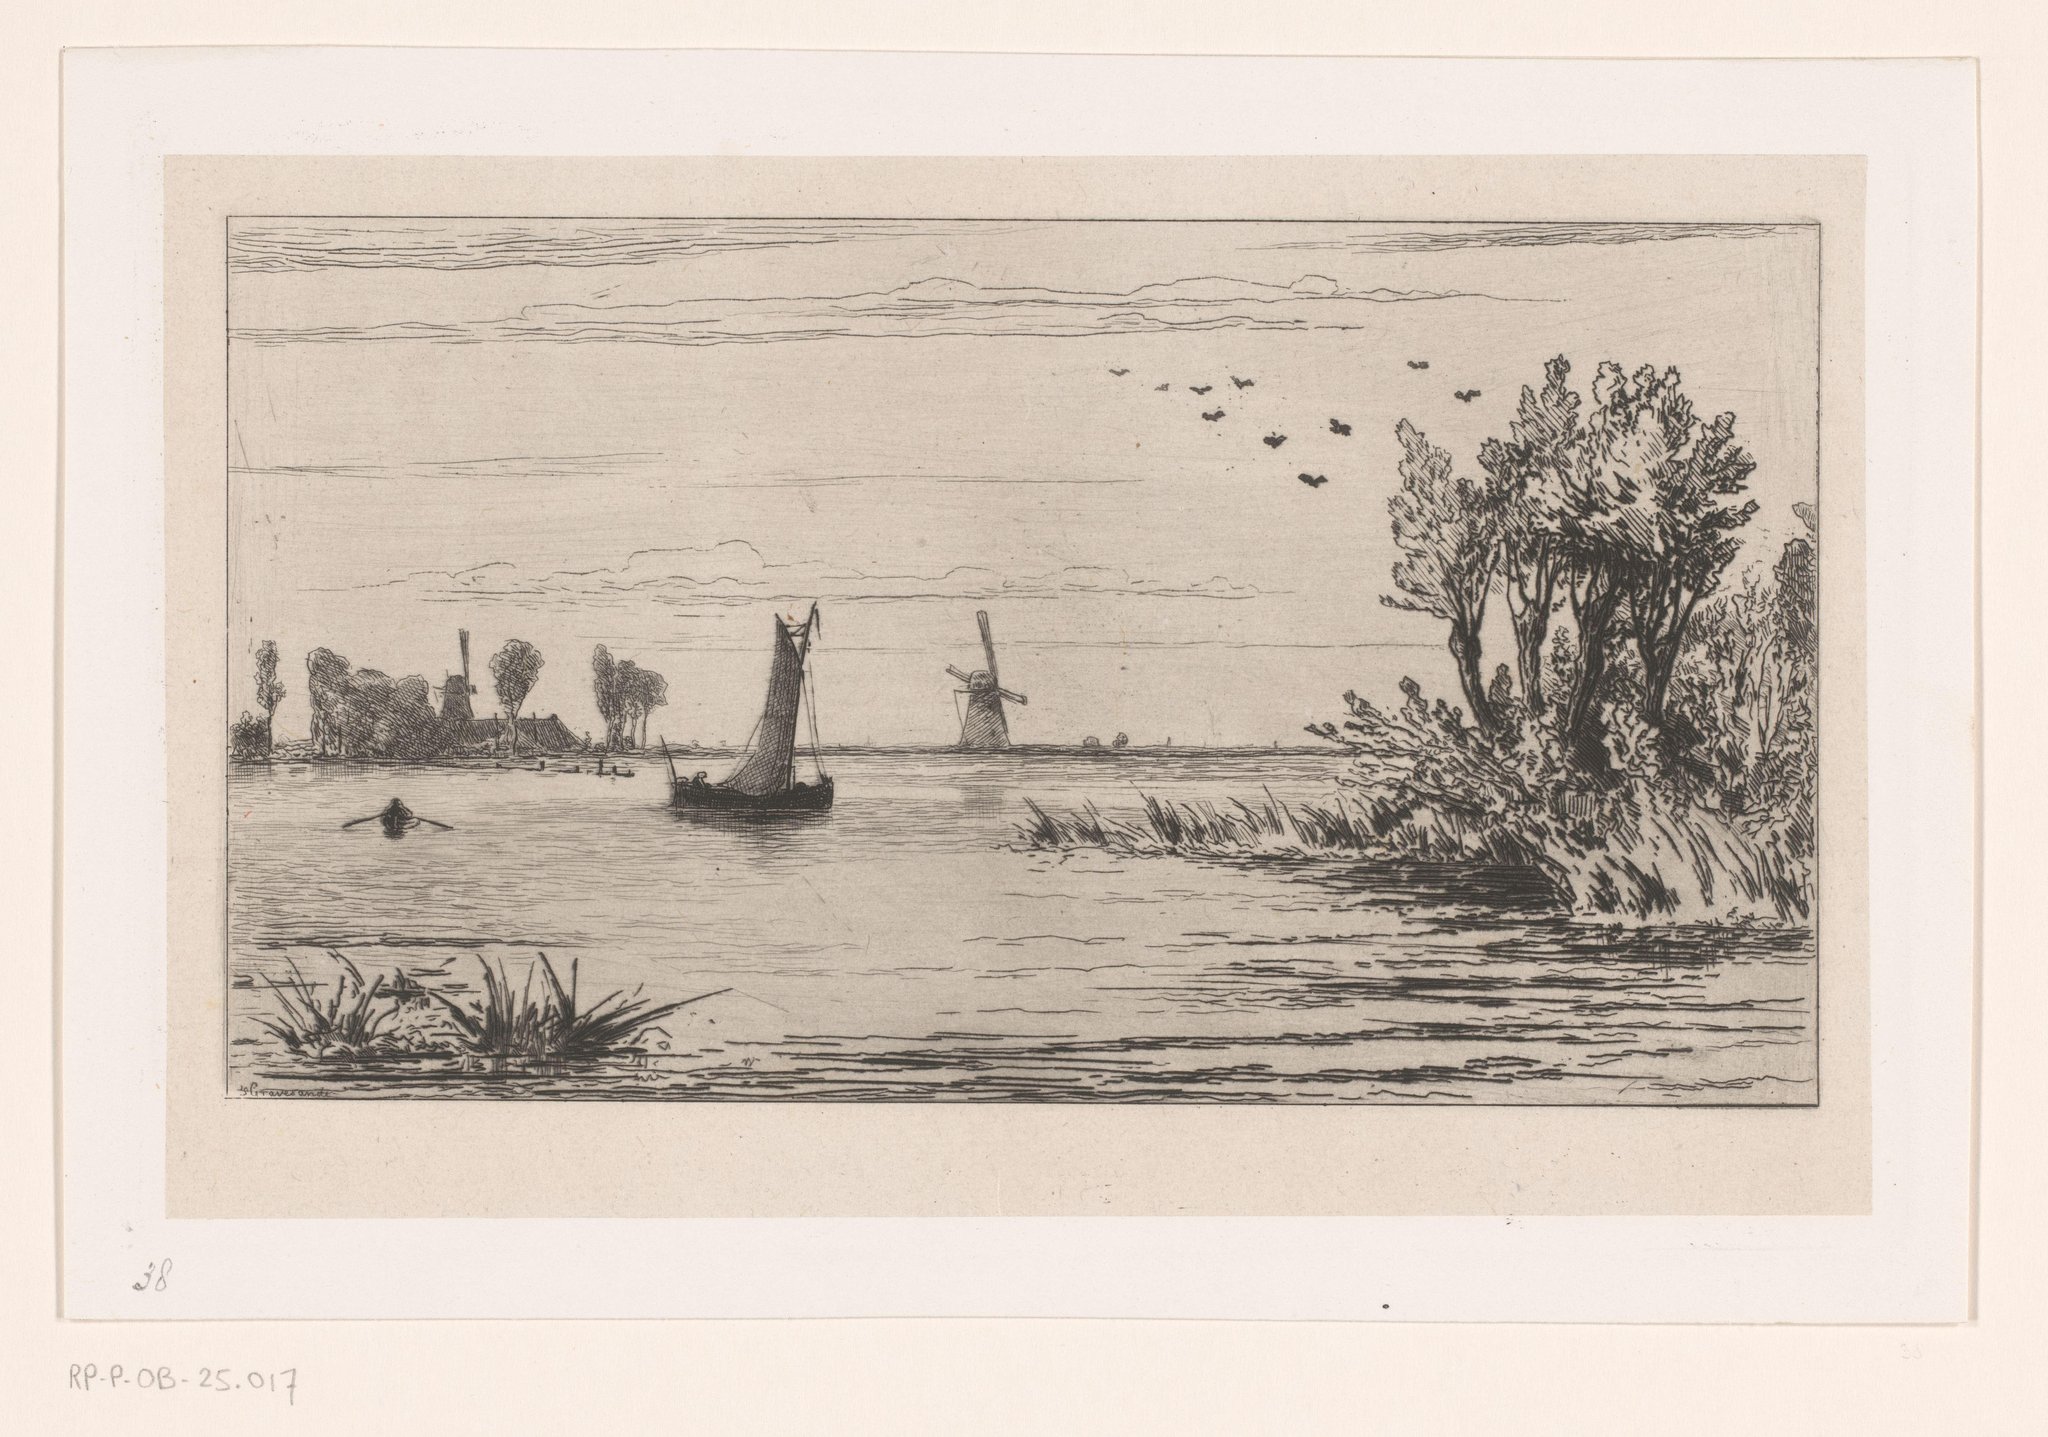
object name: print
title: Abcoudermeer met roeiboot en zeilboot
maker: carel nicolaas storm van s-gravesande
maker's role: draughtsman, print maker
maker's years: 1841-1924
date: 1872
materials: paper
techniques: etching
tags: lake, windmill in landscape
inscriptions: collector's mark: Lugt 2228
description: Gezicht op het Abcoudermeer met aan de horizon twee molens. Op het meer varen een roeiboot en een zeilboot.